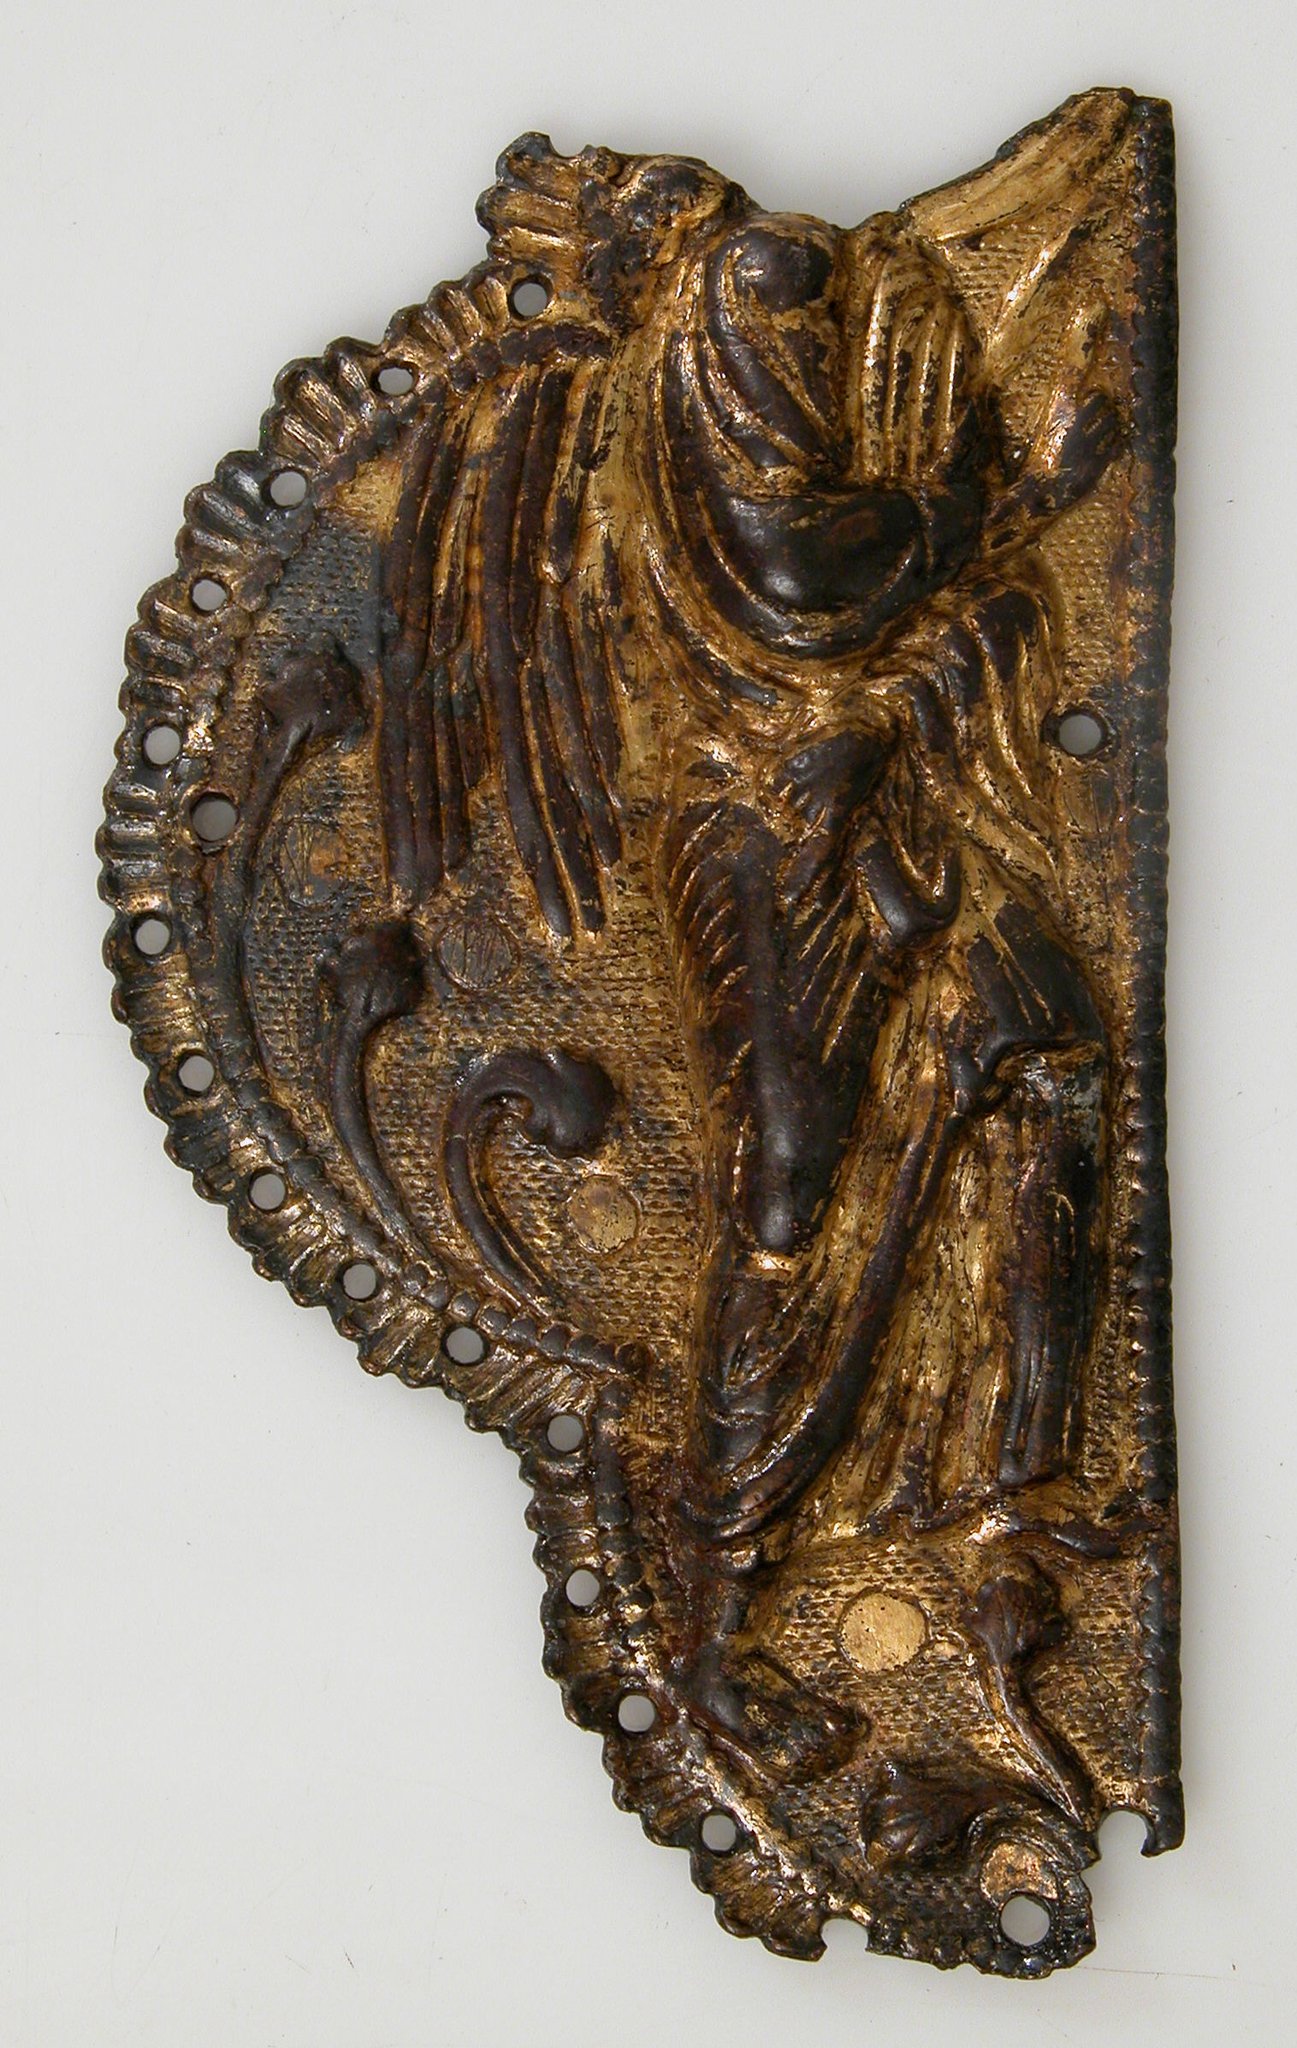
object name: morse fragment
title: Morse Fragment with the Archangel Gabriel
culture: french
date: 1250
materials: copper, gilt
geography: france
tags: women